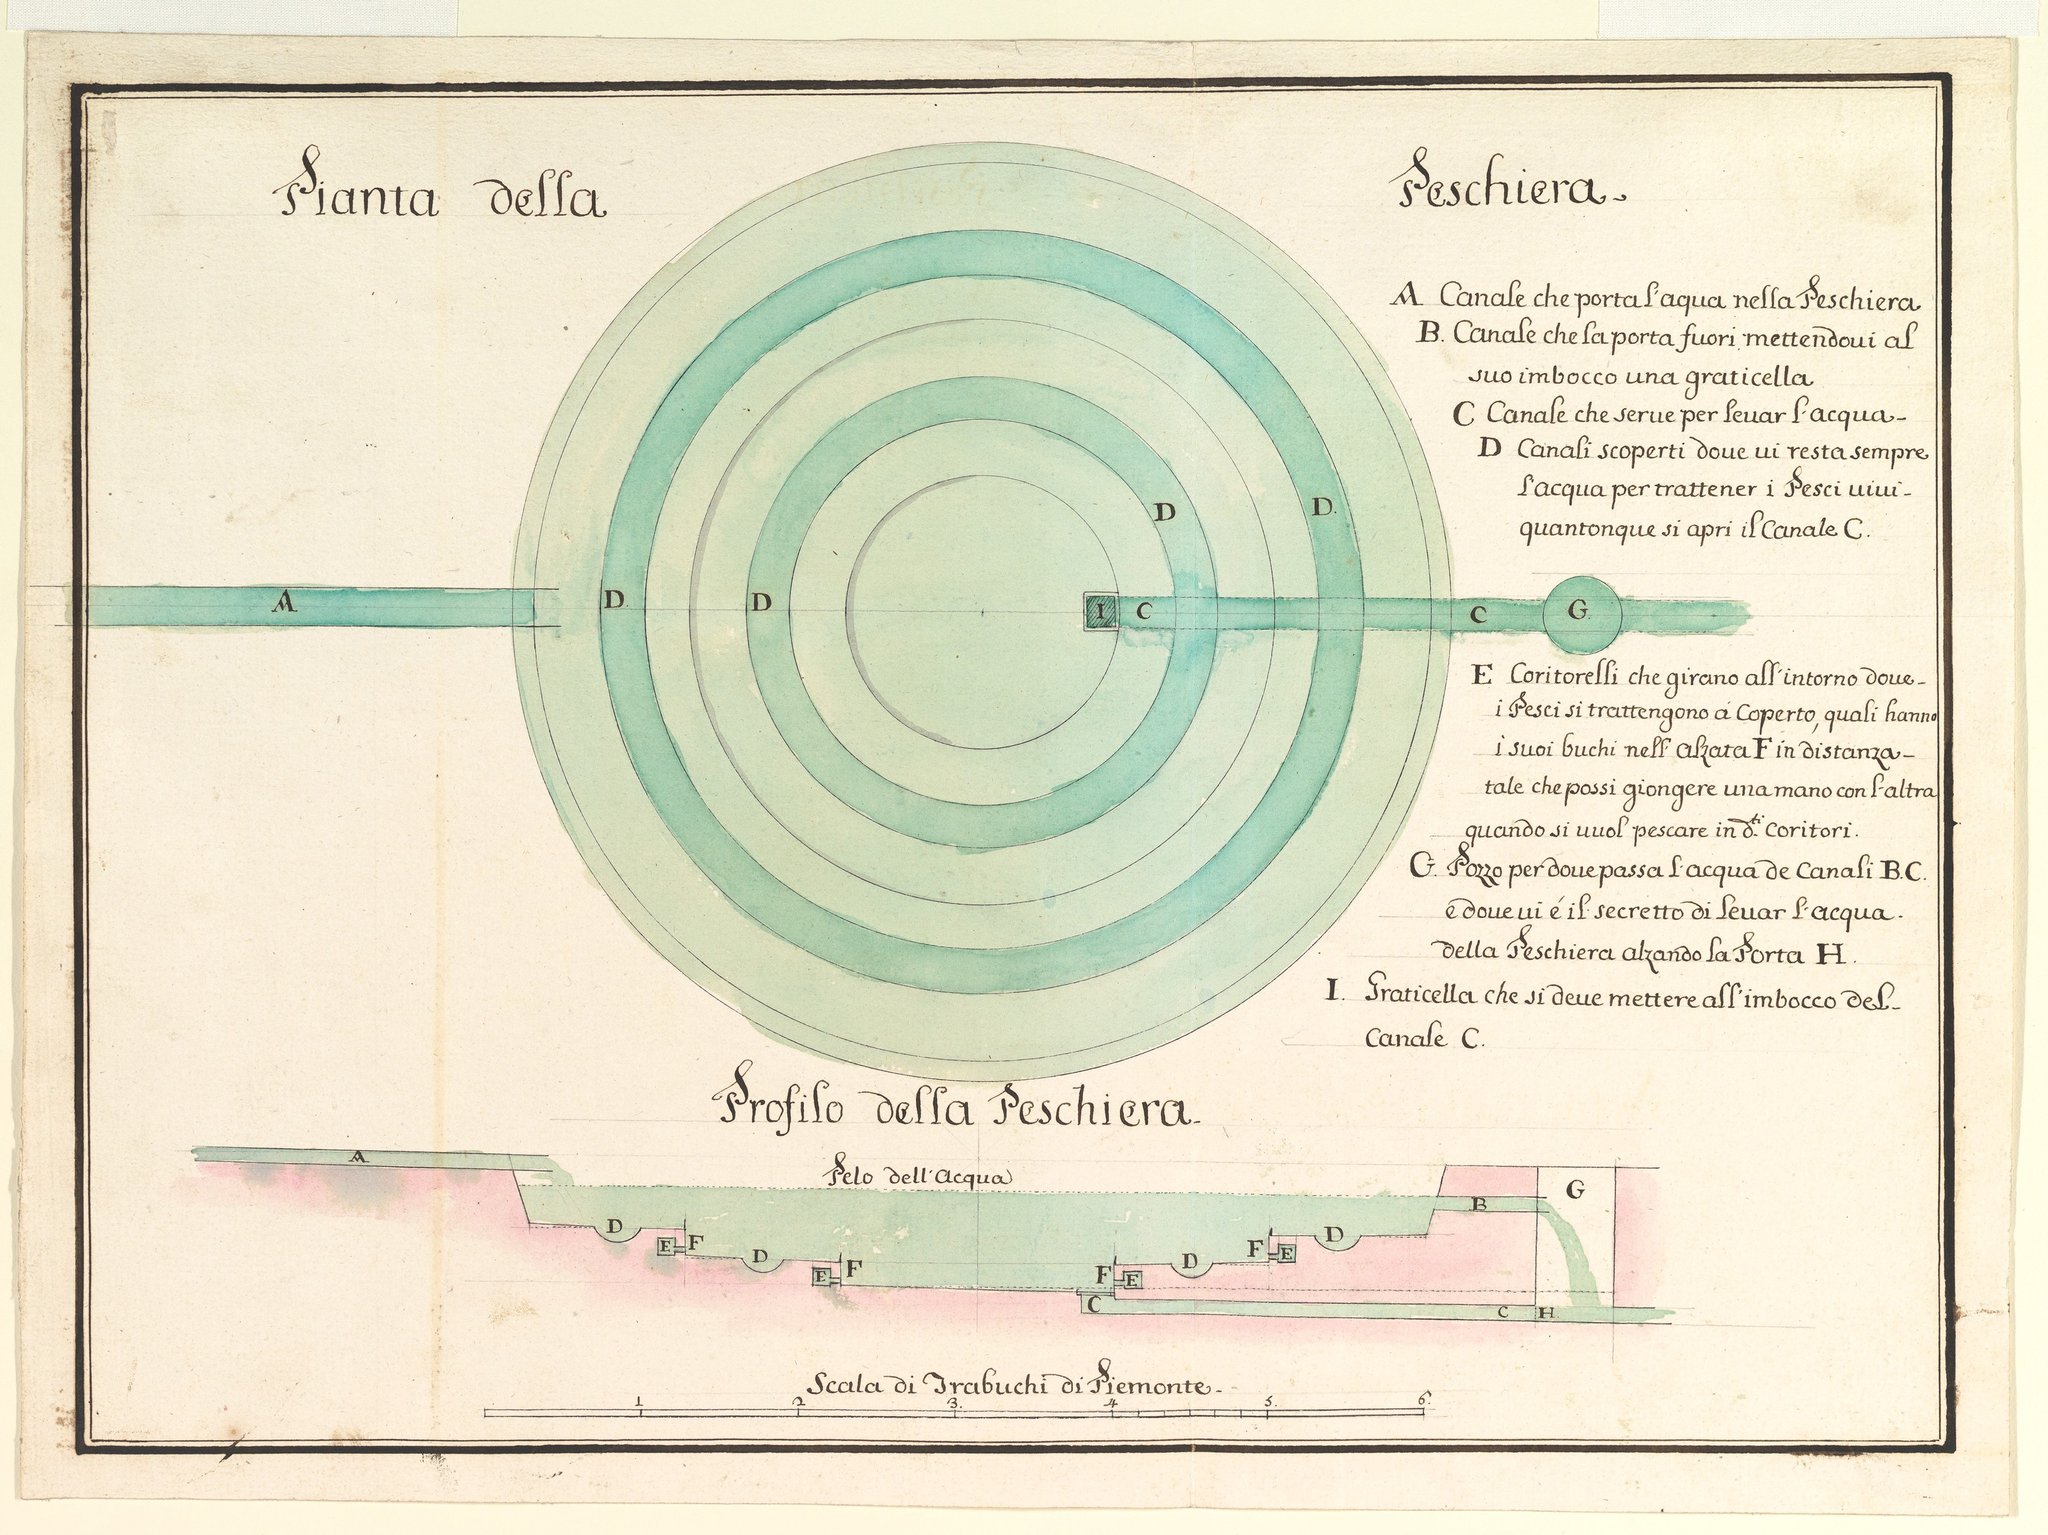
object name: drawing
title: Design for a Fish-Pond in Plan and Section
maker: anonymous, italian, piedmontese, 18th century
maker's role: artist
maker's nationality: italian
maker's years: 1700-1800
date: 1701-1800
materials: graphite, ink, watercolor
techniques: brush, pen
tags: architecture,ponds